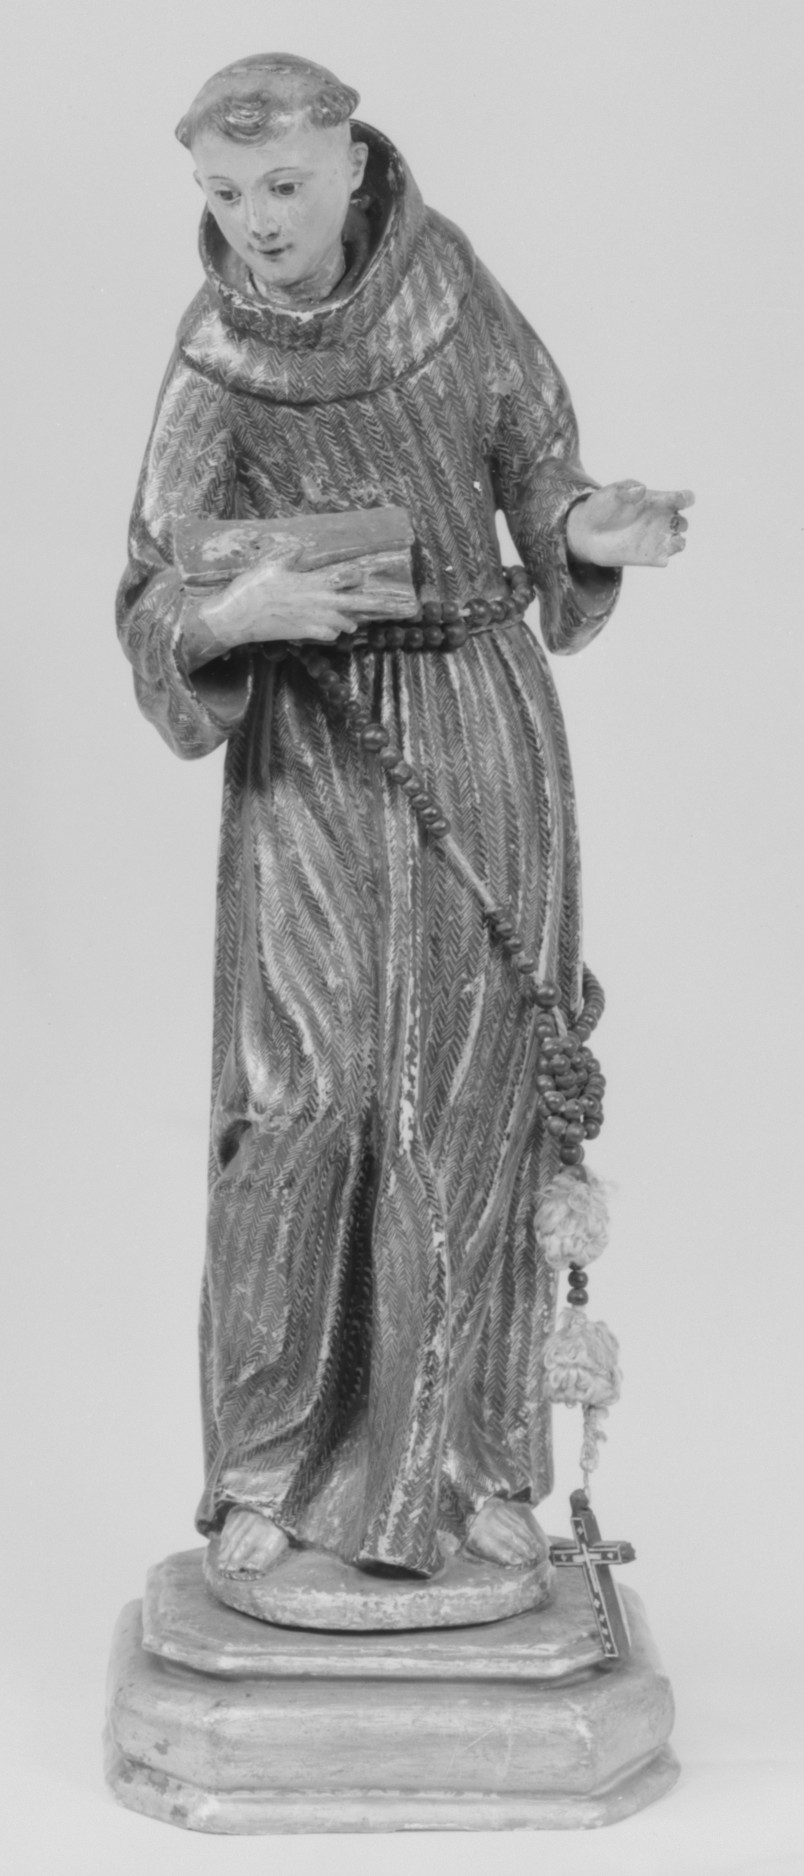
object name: statuette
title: Saint Anthony of Padua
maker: pedro de mena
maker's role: artist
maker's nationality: spanish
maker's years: 1628-1688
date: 1667-1733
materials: gesso, mother of pearl, shell, wood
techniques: gilding, inlay, polychrome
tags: saint anthony